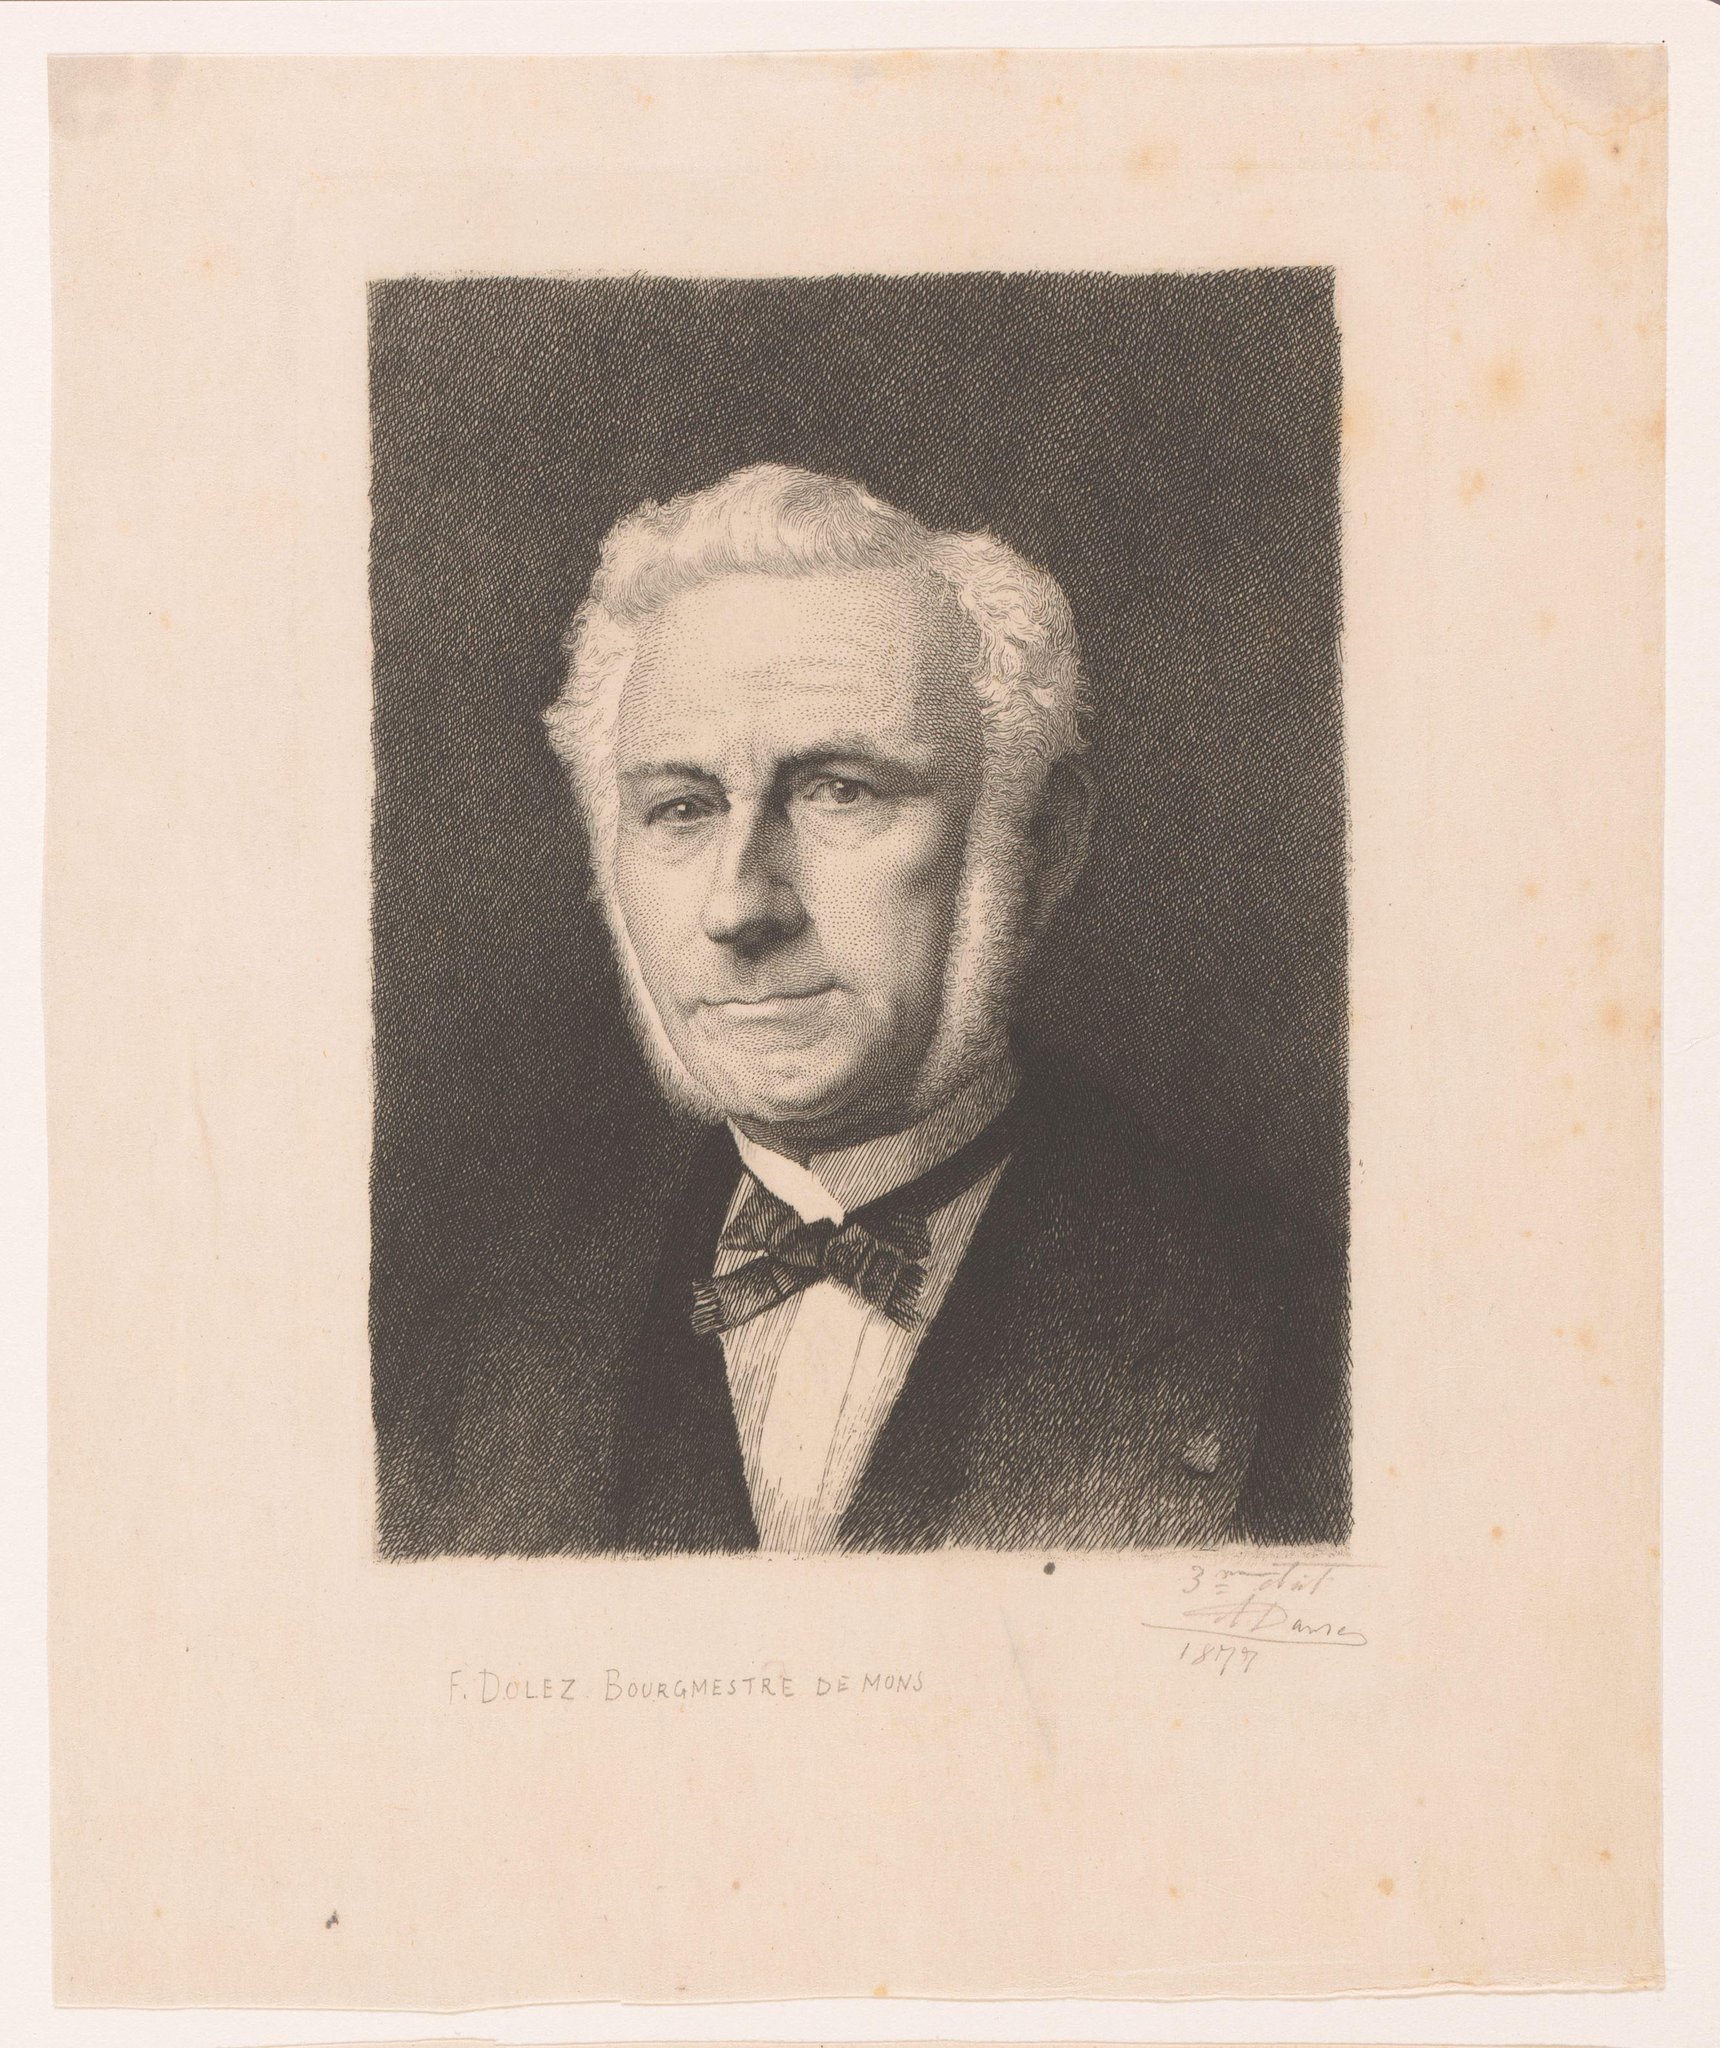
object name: print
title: Portret van François Dolez, burgemeester van Mons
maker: auguste danse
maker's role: print maker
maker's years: 1829-1929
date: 1877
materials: paper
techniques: etching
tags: historical person (...) - historical person (...) portrayed alone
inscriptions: collector's mark: Lugt 2228, annotation: ‘3me état’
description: Dezelfde prentmaker heeft meerdere portretten van Dolez geëtst, die sterk op elkaar lijken. Zie RP-P-1909-3497 t/m RP-P-1909-3503.